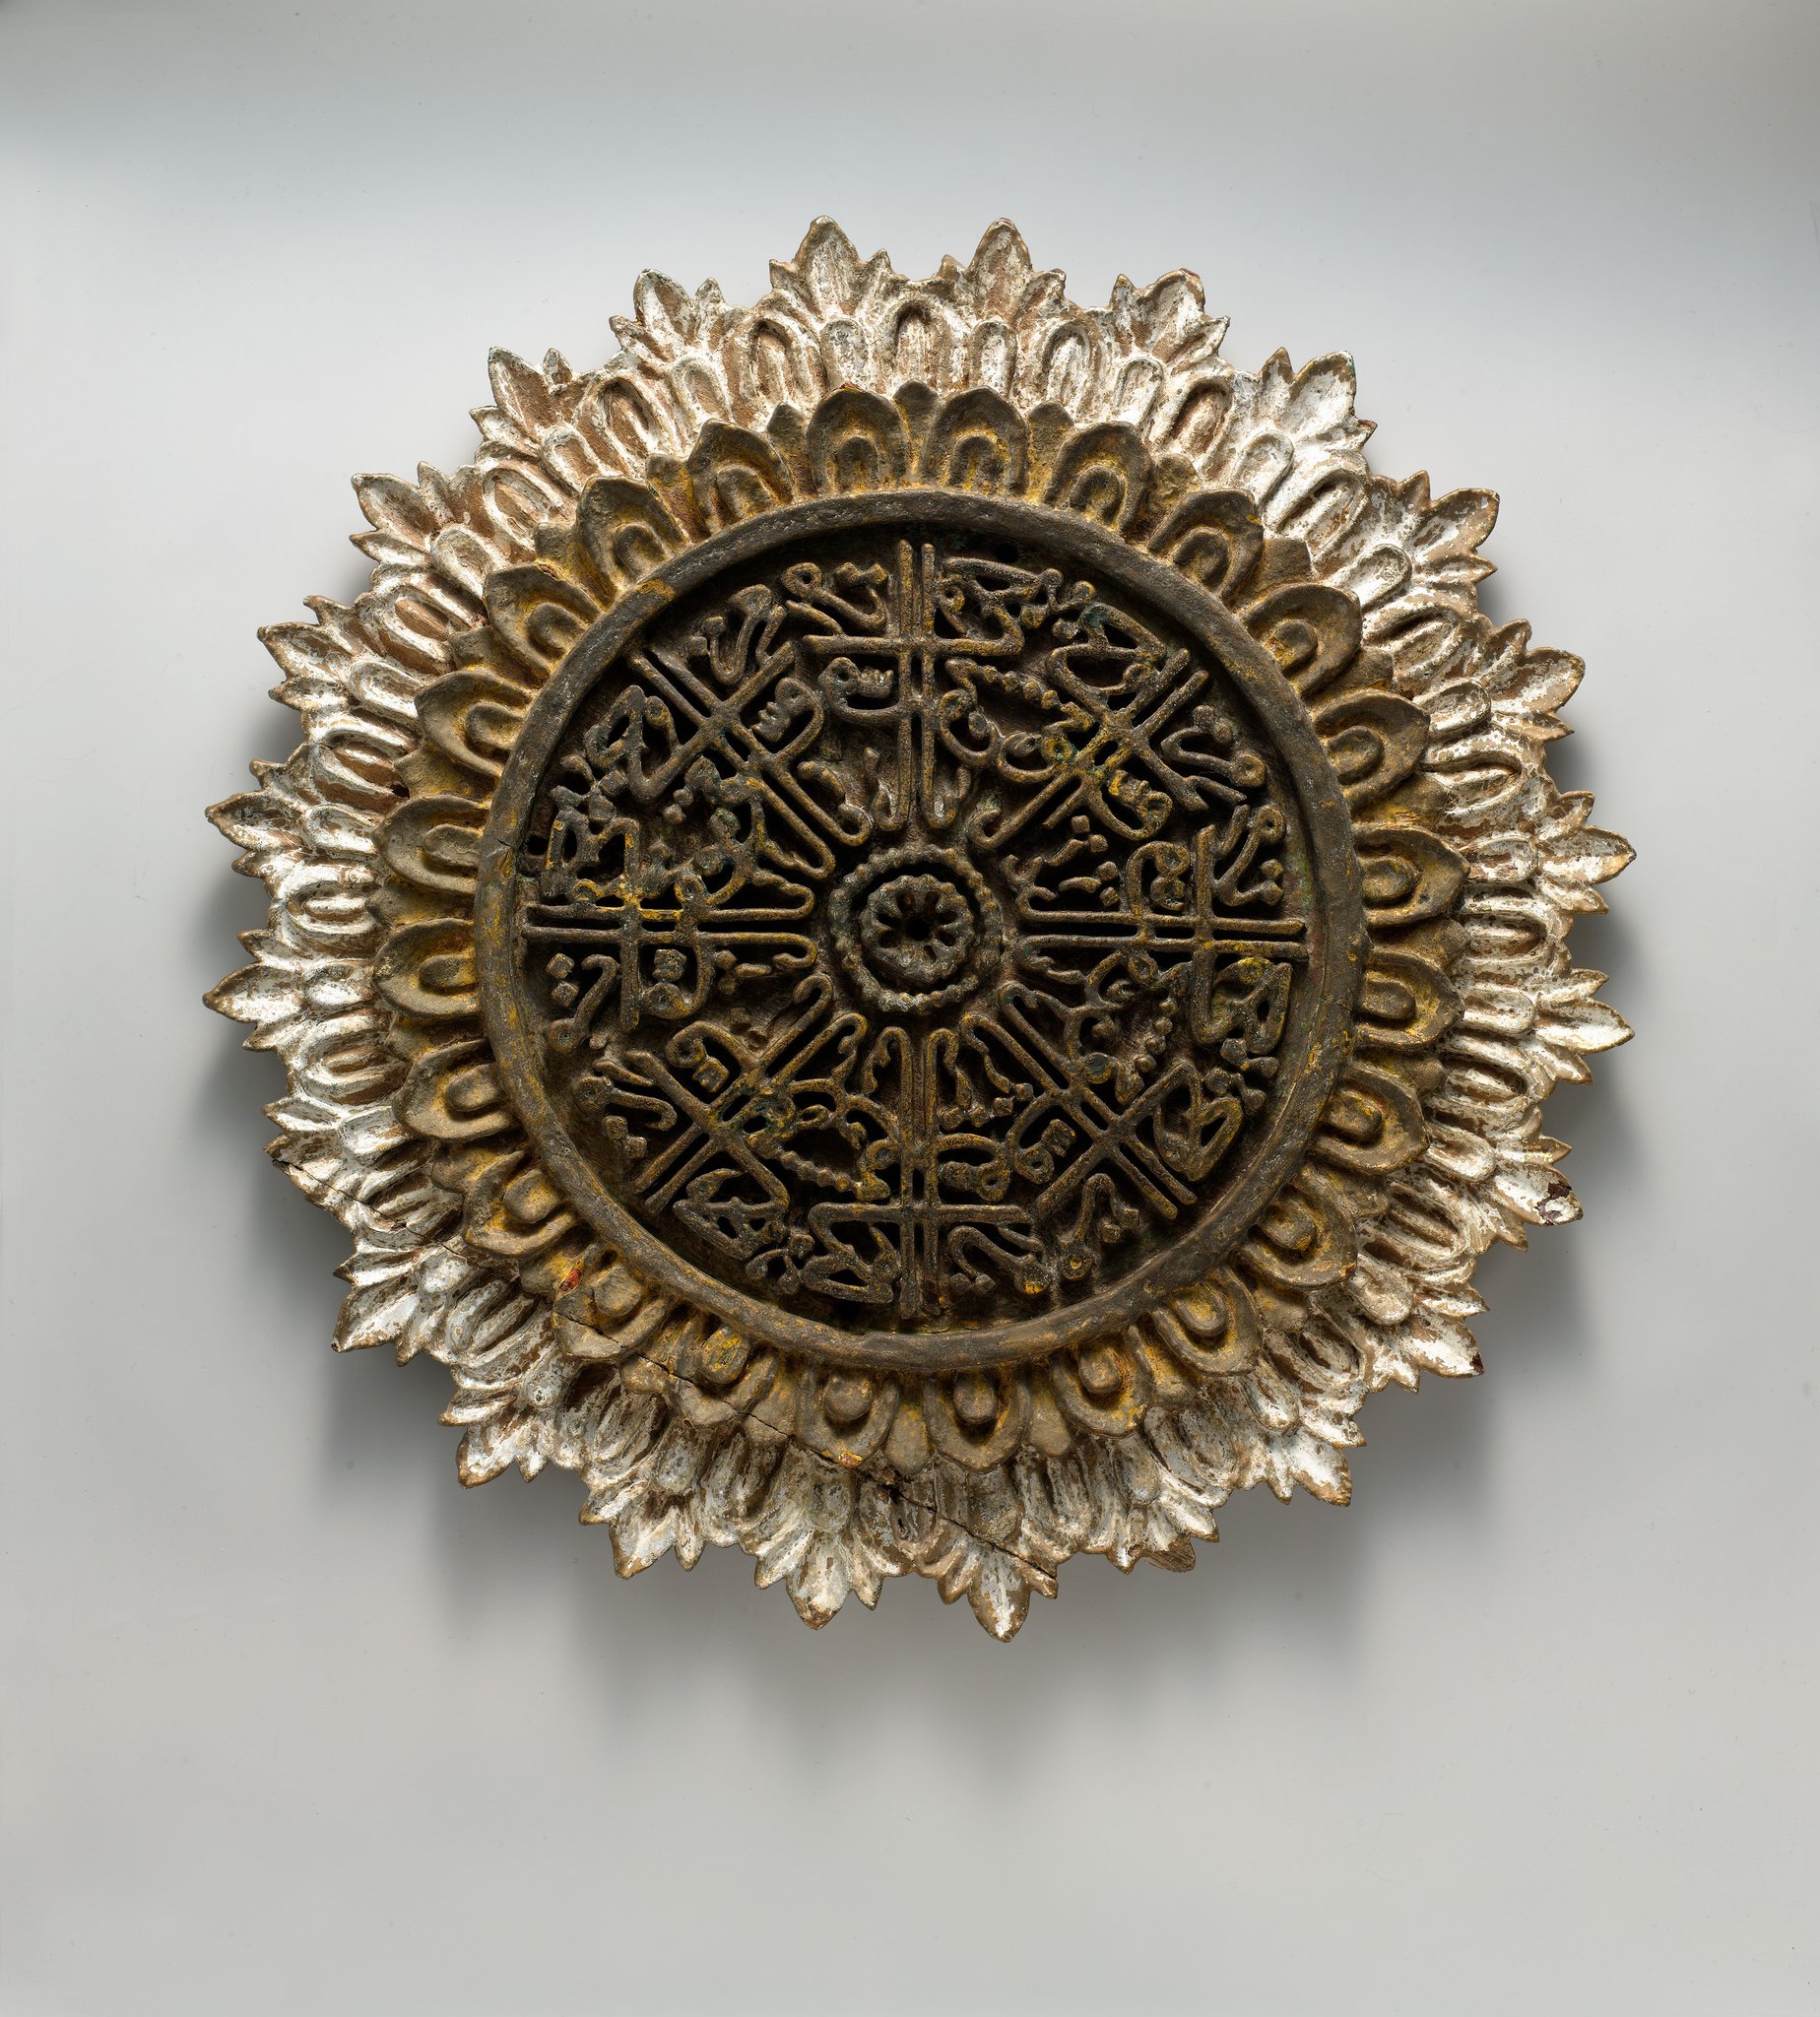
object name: roundel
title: Roundel with Repeated Inscription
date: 1567-1600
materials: gesso, gold, metal, silver, wood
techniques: painting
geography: india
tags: arabic